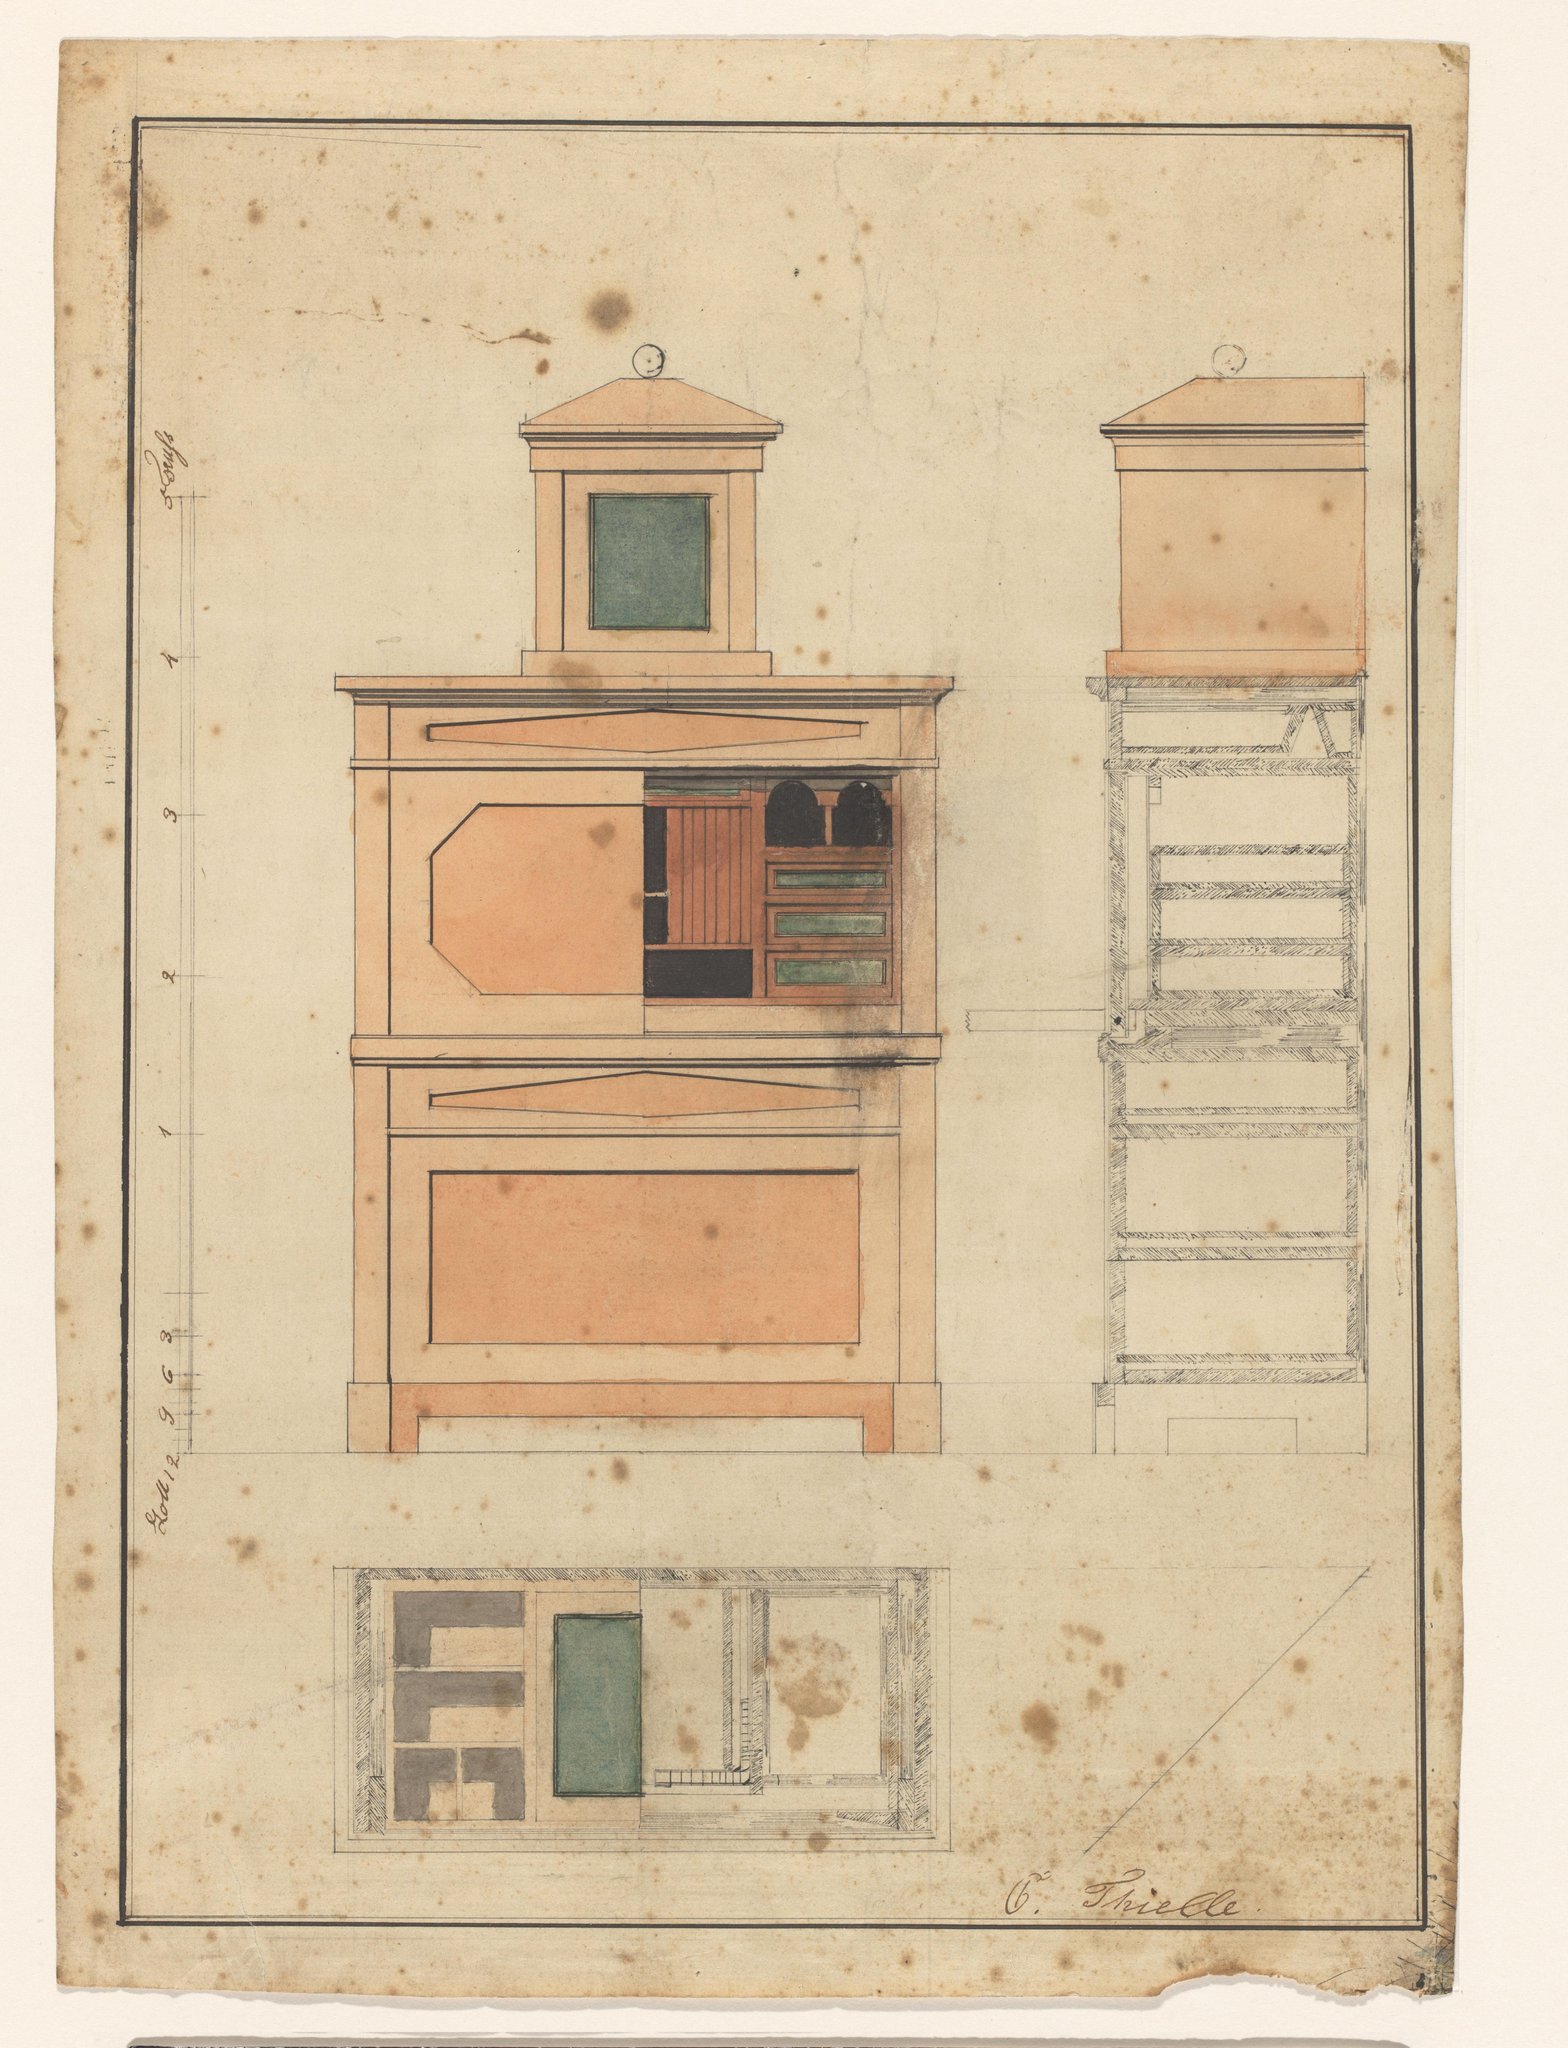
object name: design drawing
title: Ontwerp voor een secretaire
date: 1825-1835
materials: ink, paper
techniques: brush, pen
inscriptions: watermark: ‘VDL’, inscription: ‘Zoll 12 9 6 3 1 2 3 4 5 Fuss’, signature: ‘C. Thielle’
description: Opstand met een bol, voor- en zijaanzicht, met daaronder een in tweeën gedeelde plattegrond, links een maatverdeling.